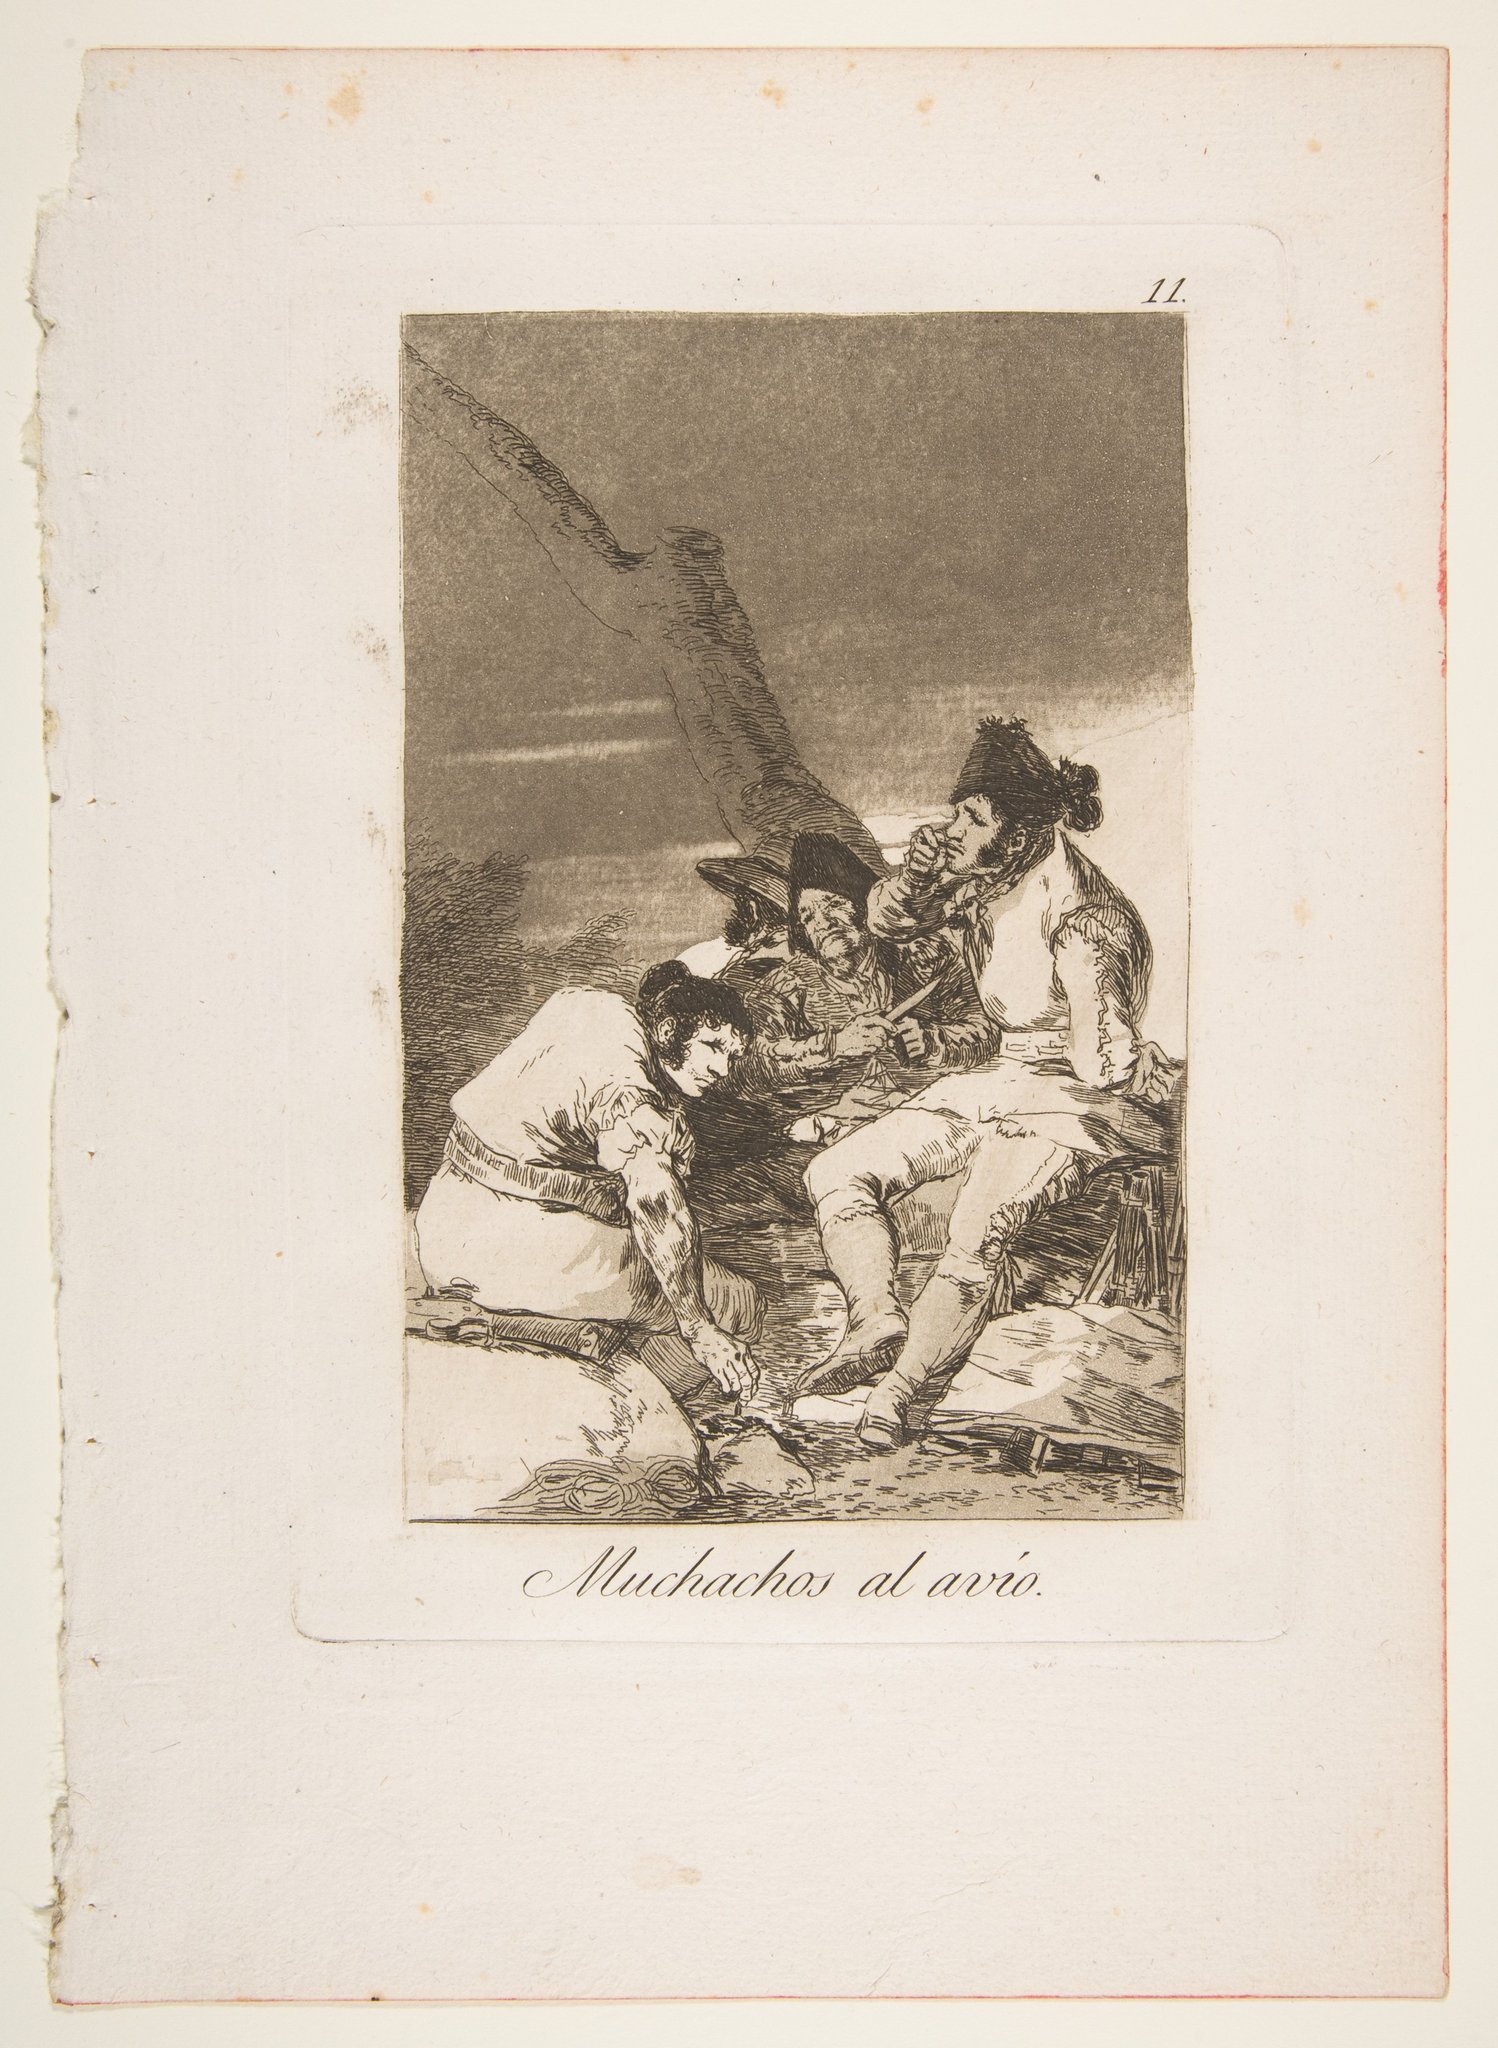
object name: print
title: Plate 11 from "Los Caprichos": Lads Making Ready (Muchachos al Avío)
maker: goya (francisco de goya y lucientes)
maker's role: artist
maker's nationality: spanish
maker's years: 1746-1828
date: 1799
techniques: aquatint, engraving, burnishing, etching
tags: men